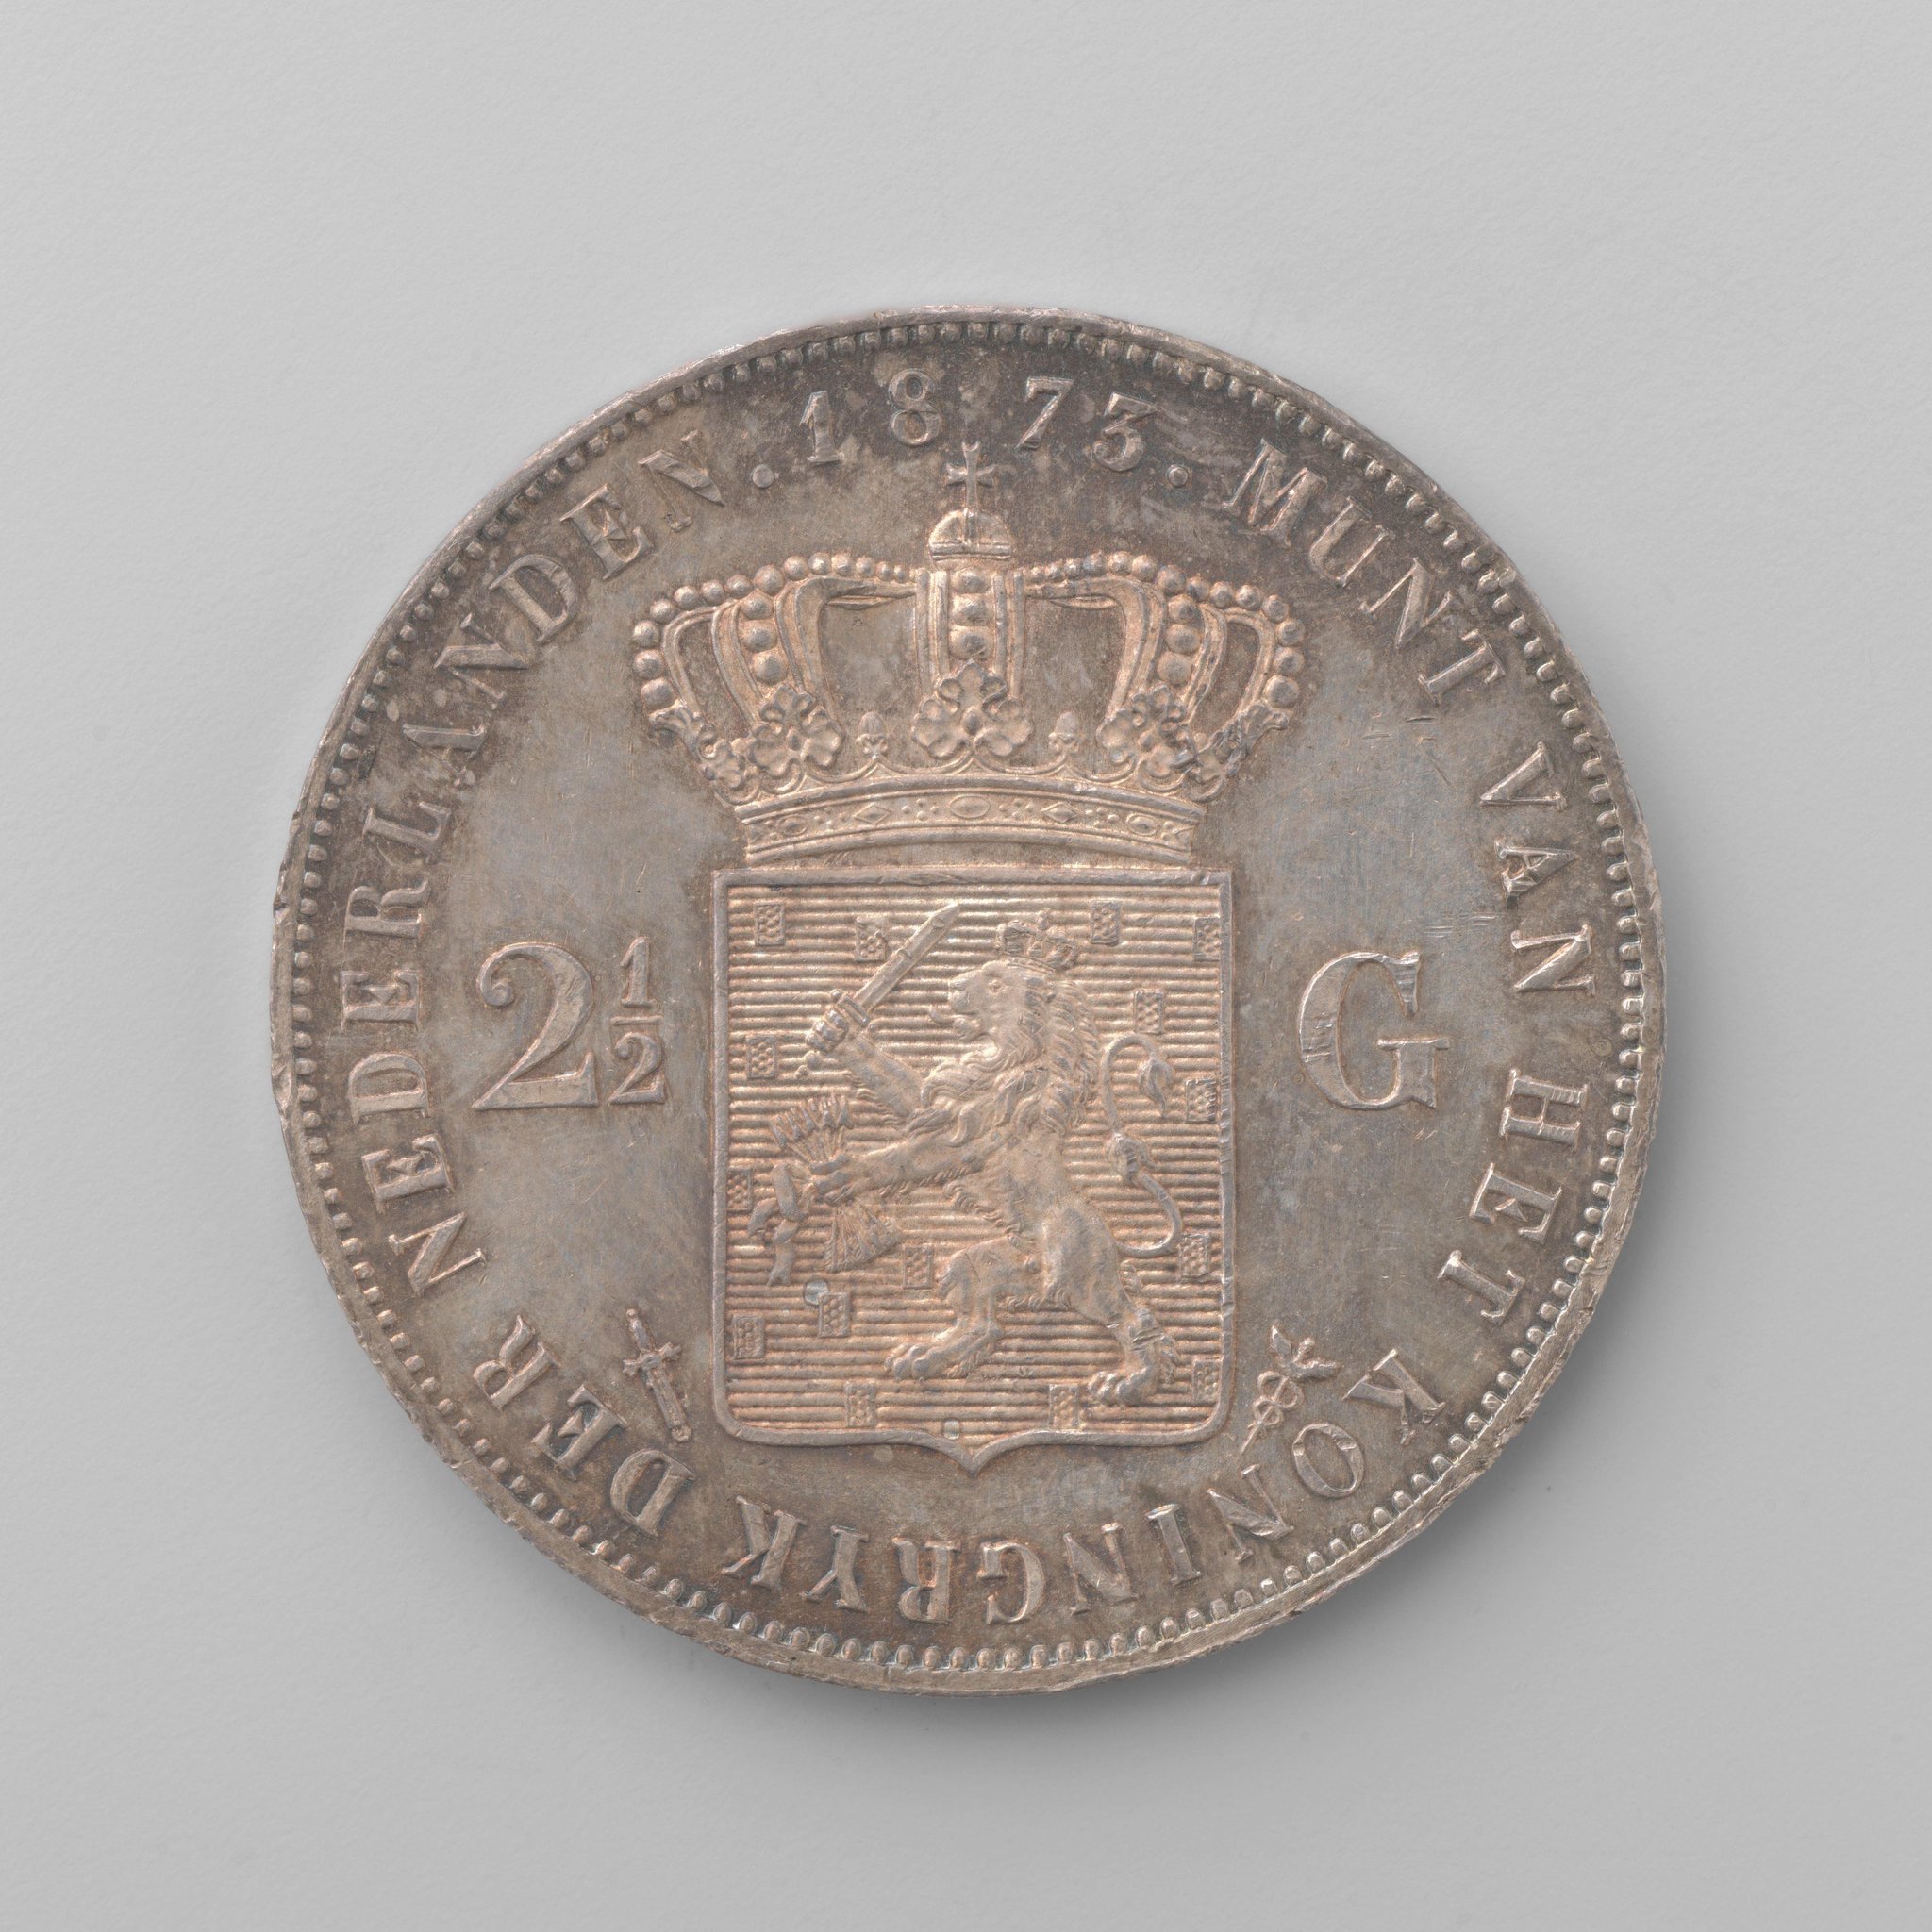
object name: twee en een halve gulden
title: Nederlandse 2½ gulden, 1873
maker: willem iii (koning der nederlanden)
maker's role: koning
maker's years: 1817-1890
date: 1873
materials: silver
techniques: striking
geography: utrecht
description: Zilveren munt. Voorzijde: borstbeeld naar rechts. Keerzijde: tussen waarde-aanduiding 2½ G gekroond rijkswapenschild. Jaartal boven kroon. Randschrift.